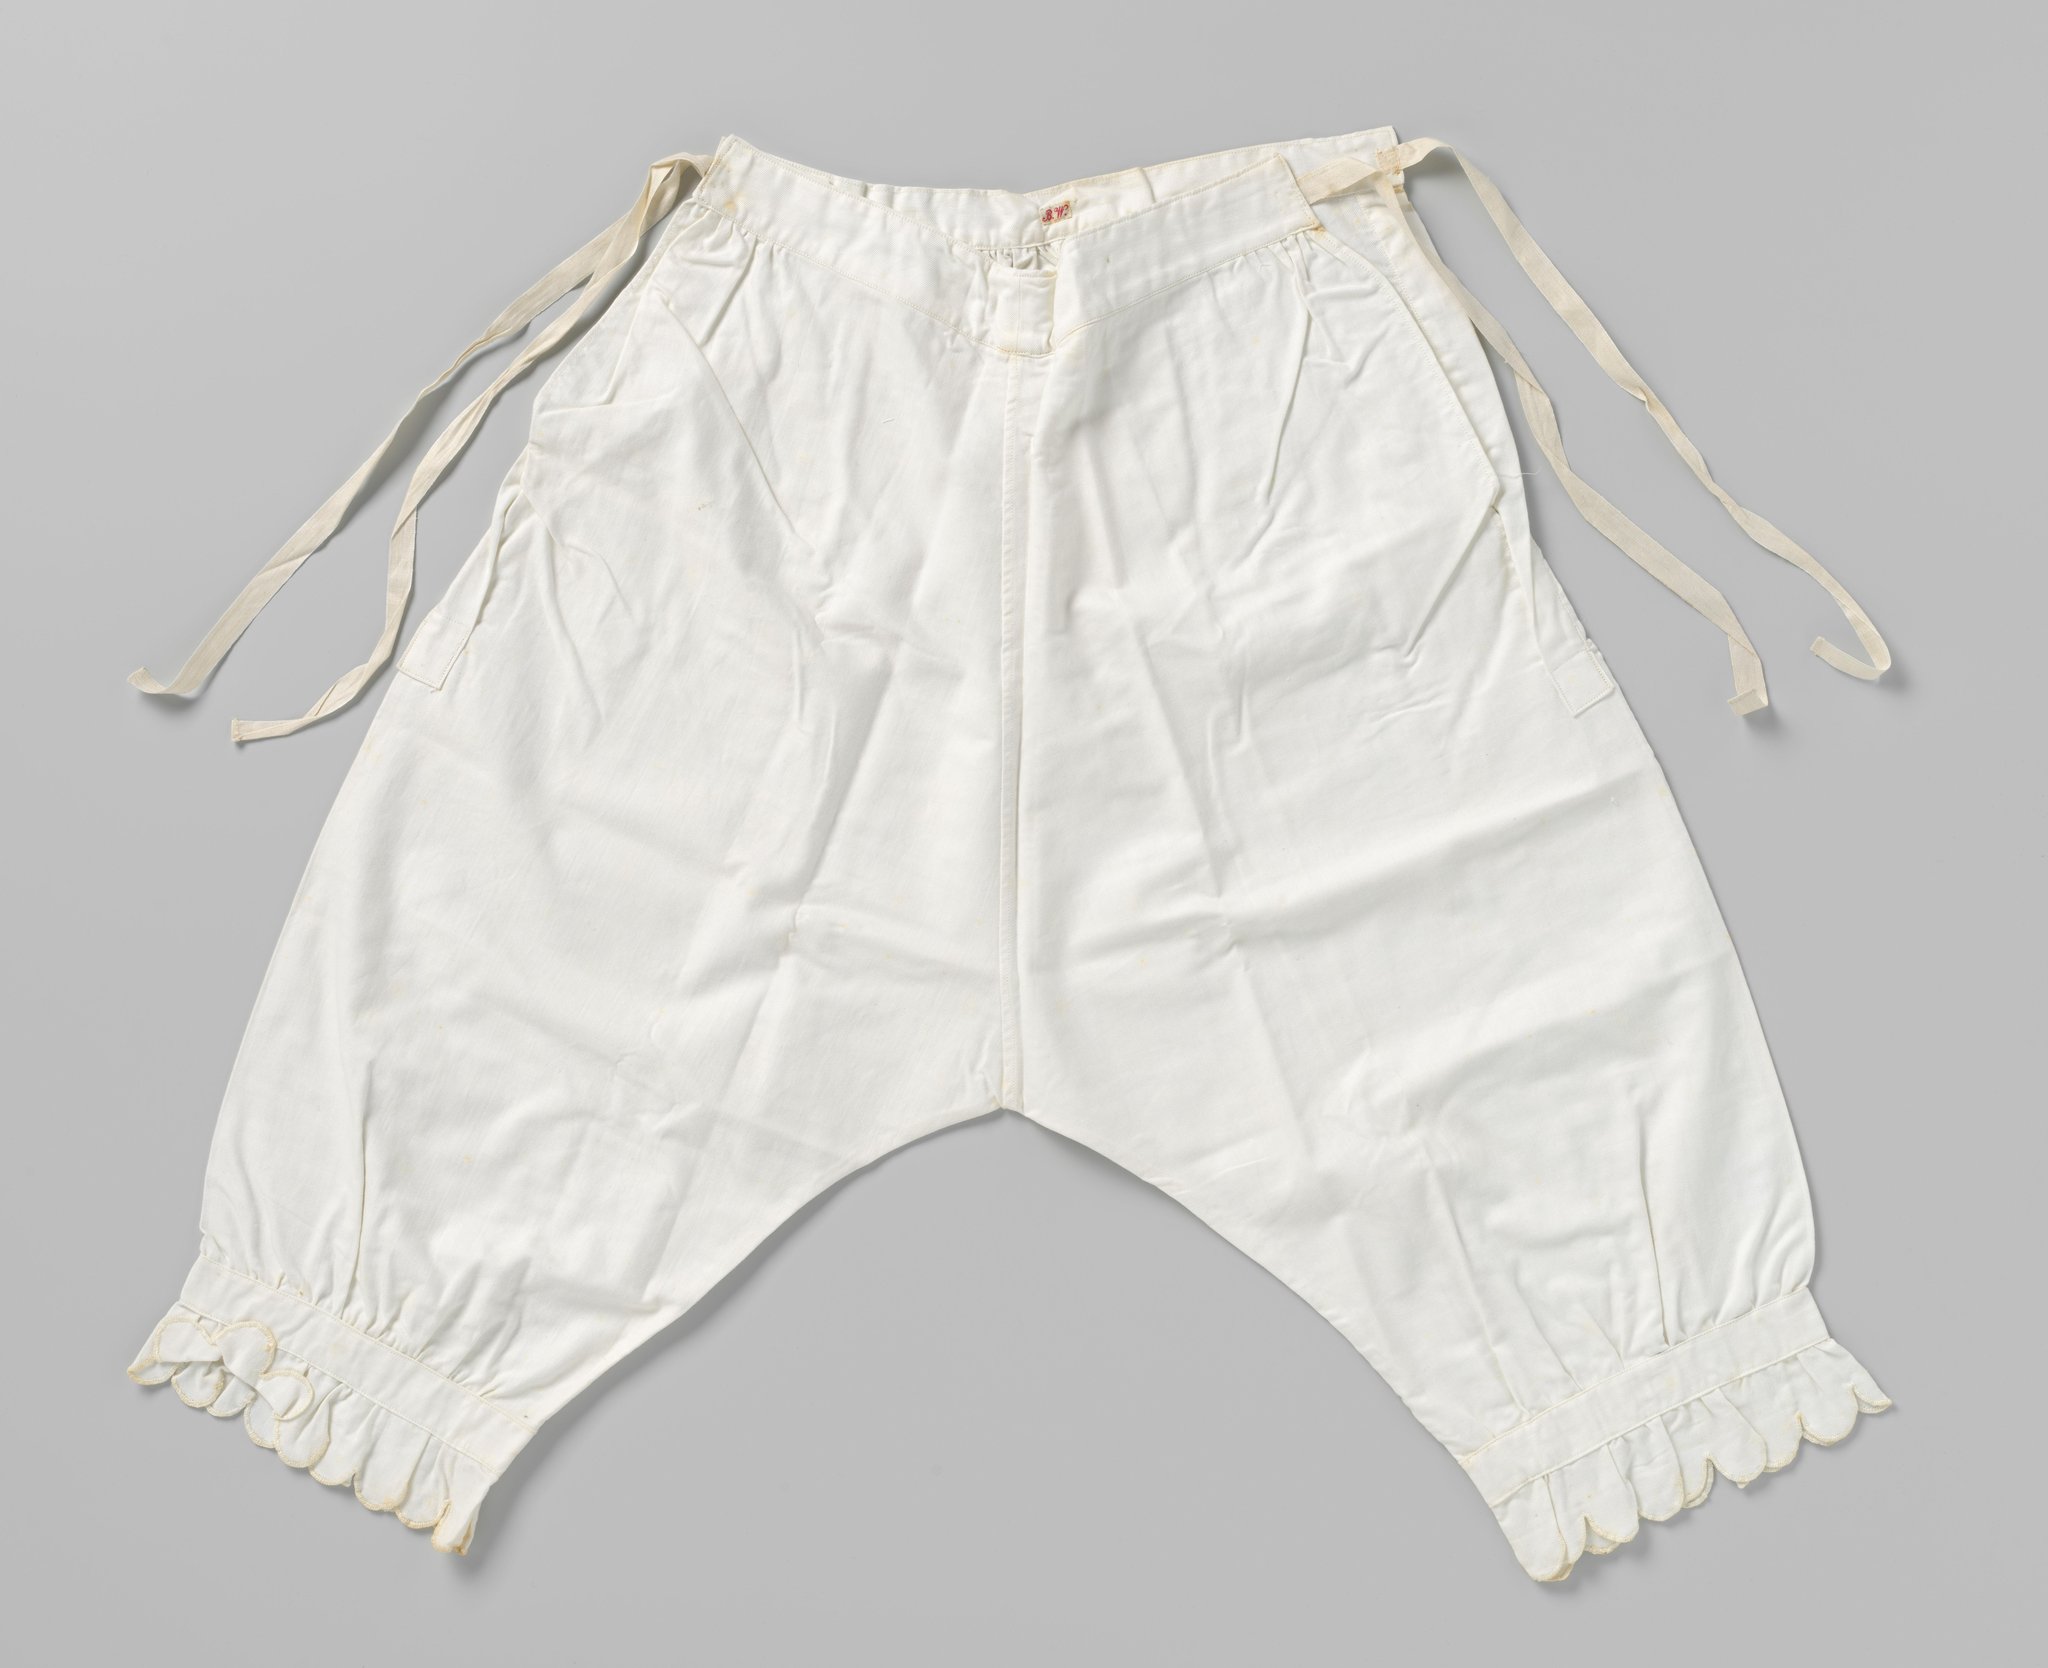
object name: underwear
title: Onderbroek met schulpstroken en Engels borduurwerk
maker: Anonymous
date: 1880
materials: cotton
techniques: weave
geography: netherlands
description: Gekocht bij de Bijenkorf. Gemaakt van 'madapolam': een sterke katoenen stof, die vooral in de periode 1850-1939 regelmatig genoemd wordt in textiel- en modeadvertenties in kranten. (bron: inventariskaart + krantenartikelen via www.delpher.nl, september 2017)